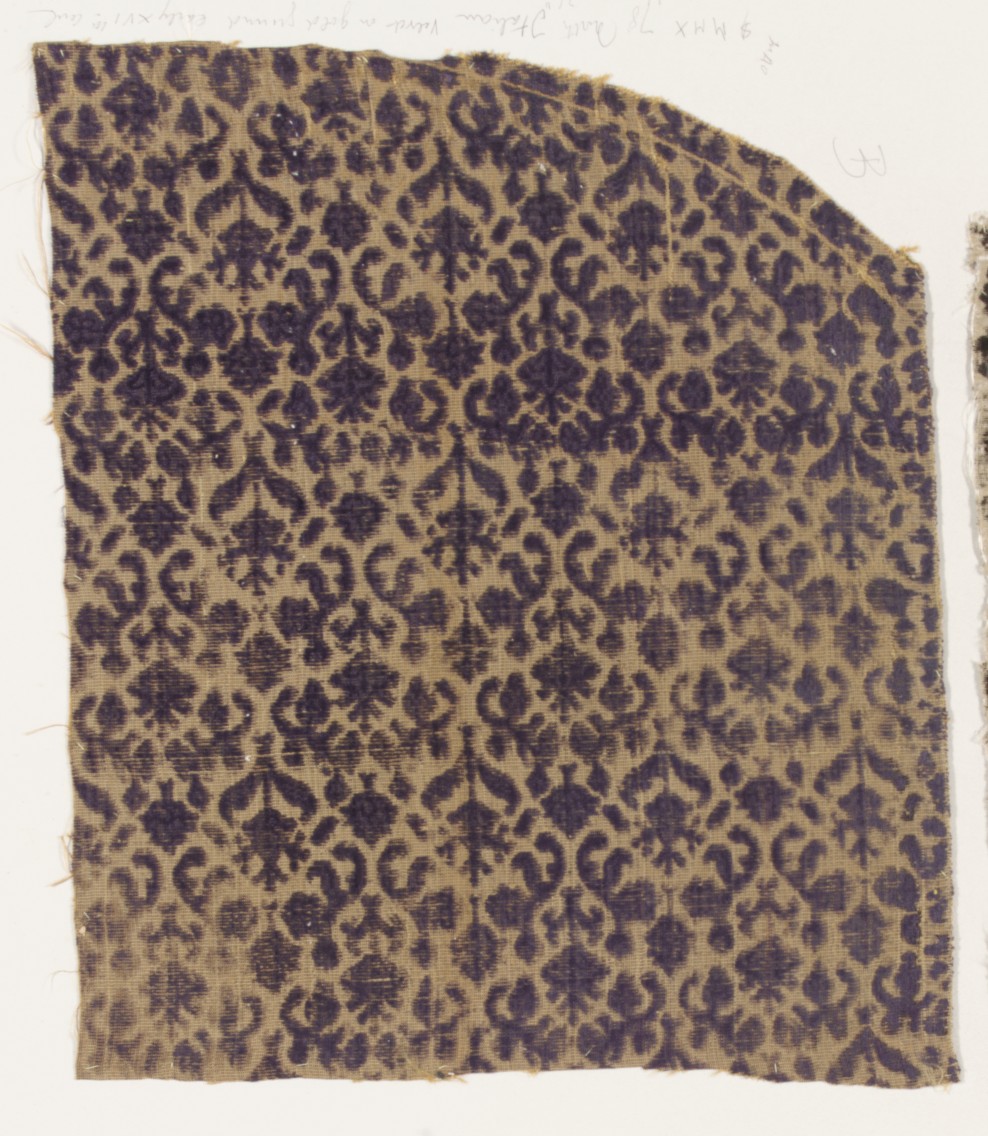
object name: fragment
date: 1501-1533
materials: metal thread, silk